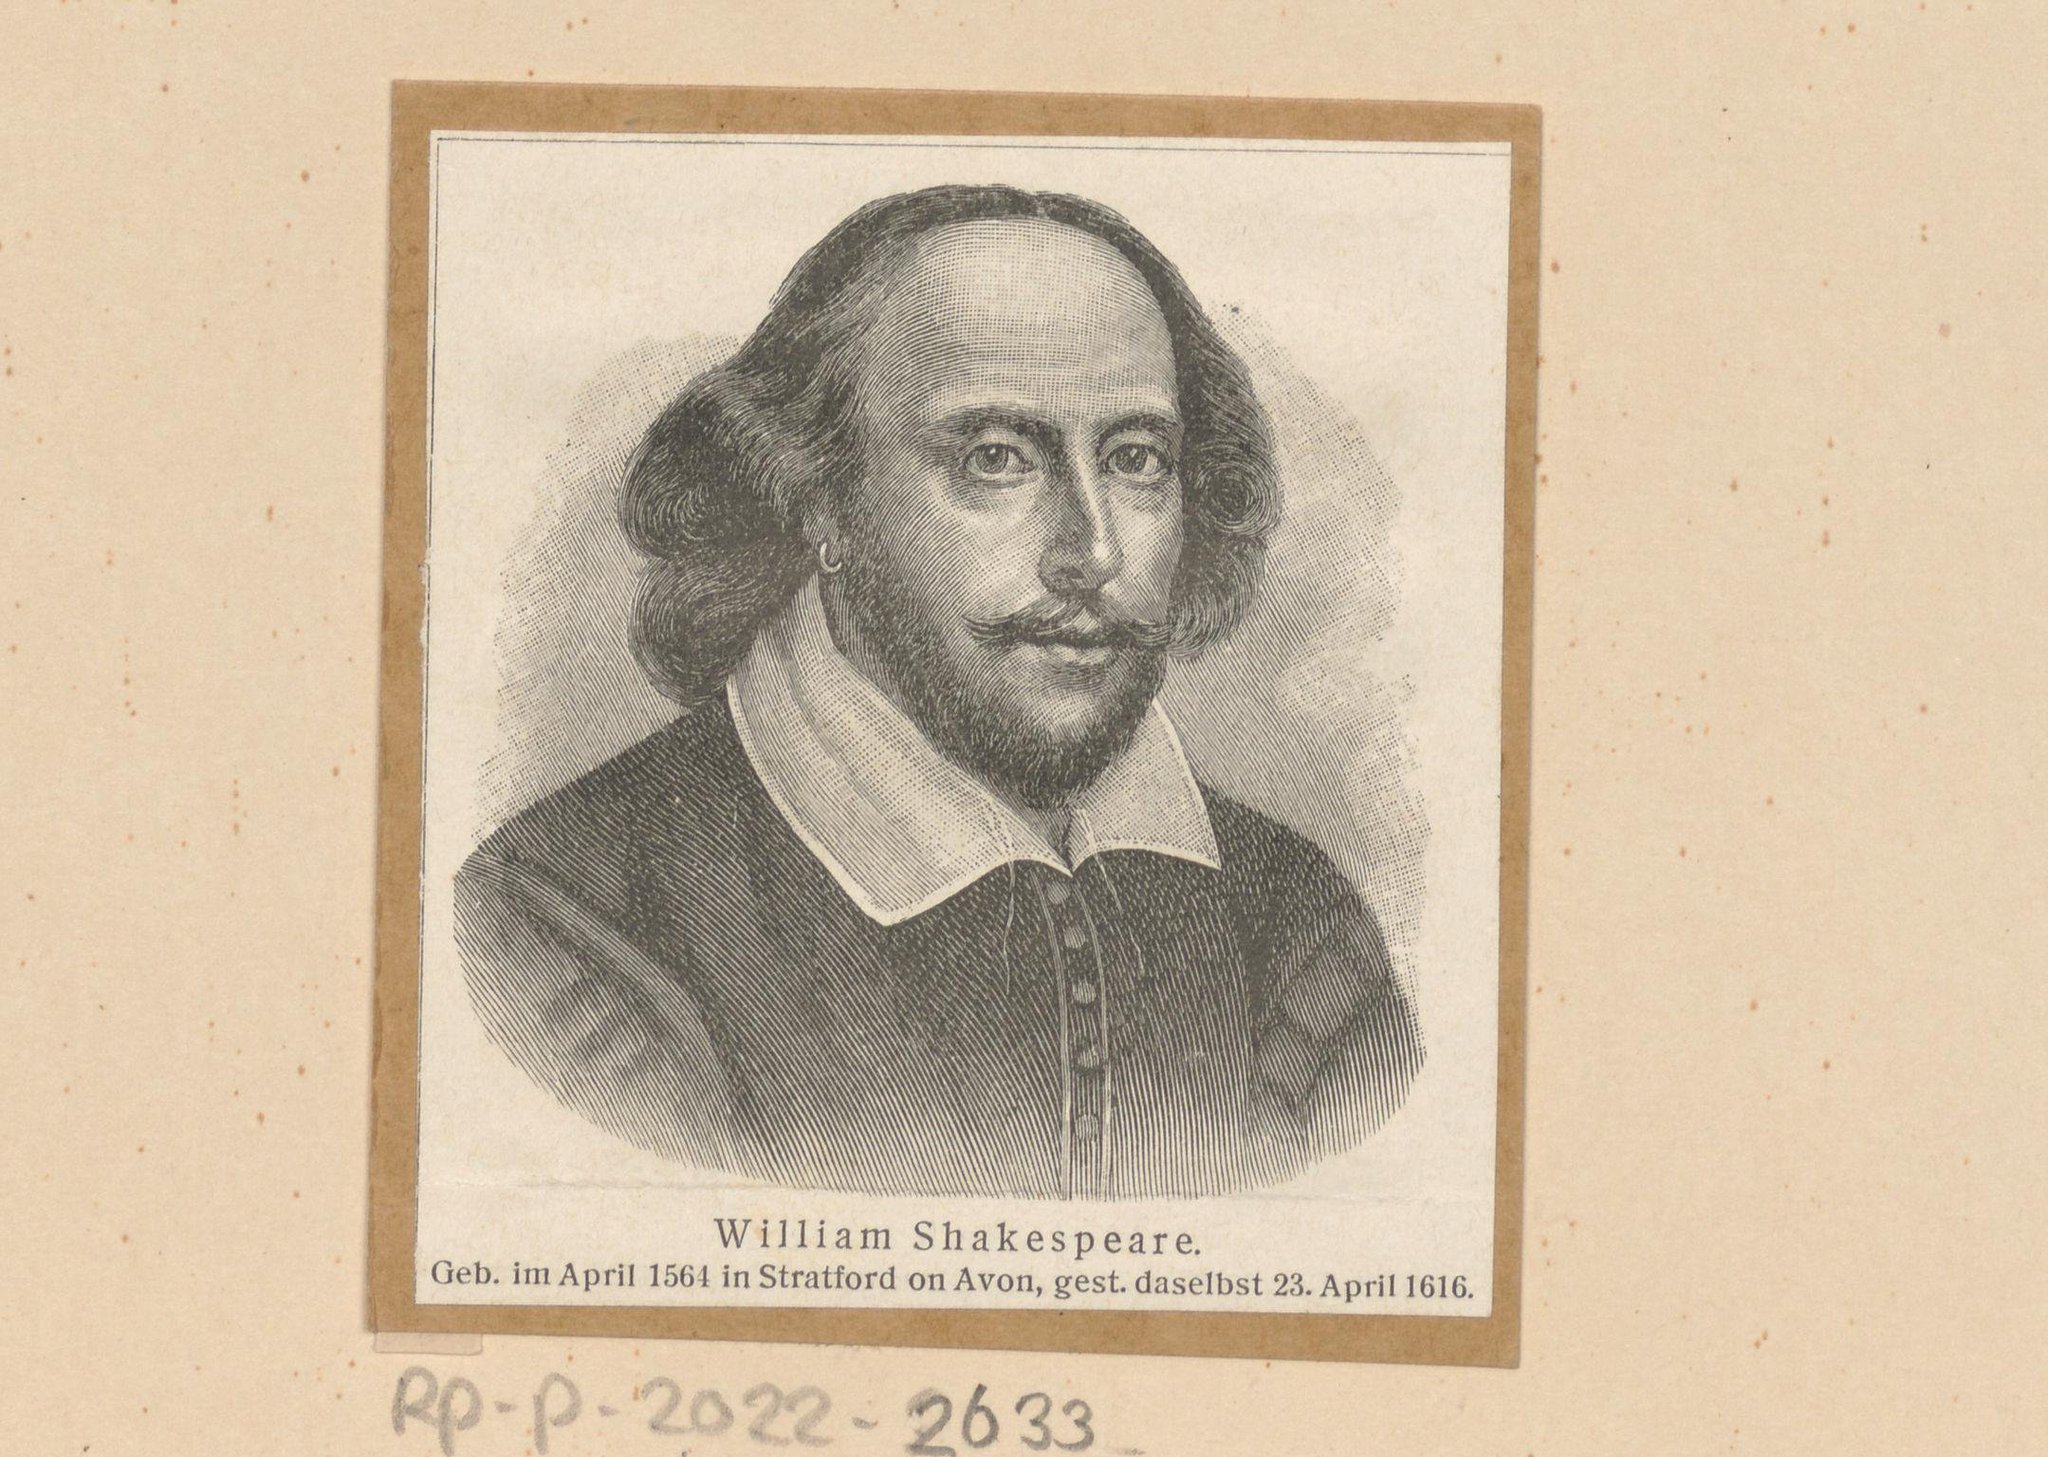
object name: print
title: Portret van William Shakespeare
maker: Anonymous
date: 1750-1899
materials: paper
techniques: letterpress printing, snipping, engraving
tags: william shakespeare, historical persons, portrait of a writer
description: Met eenregelig onderschrift in het Duits.